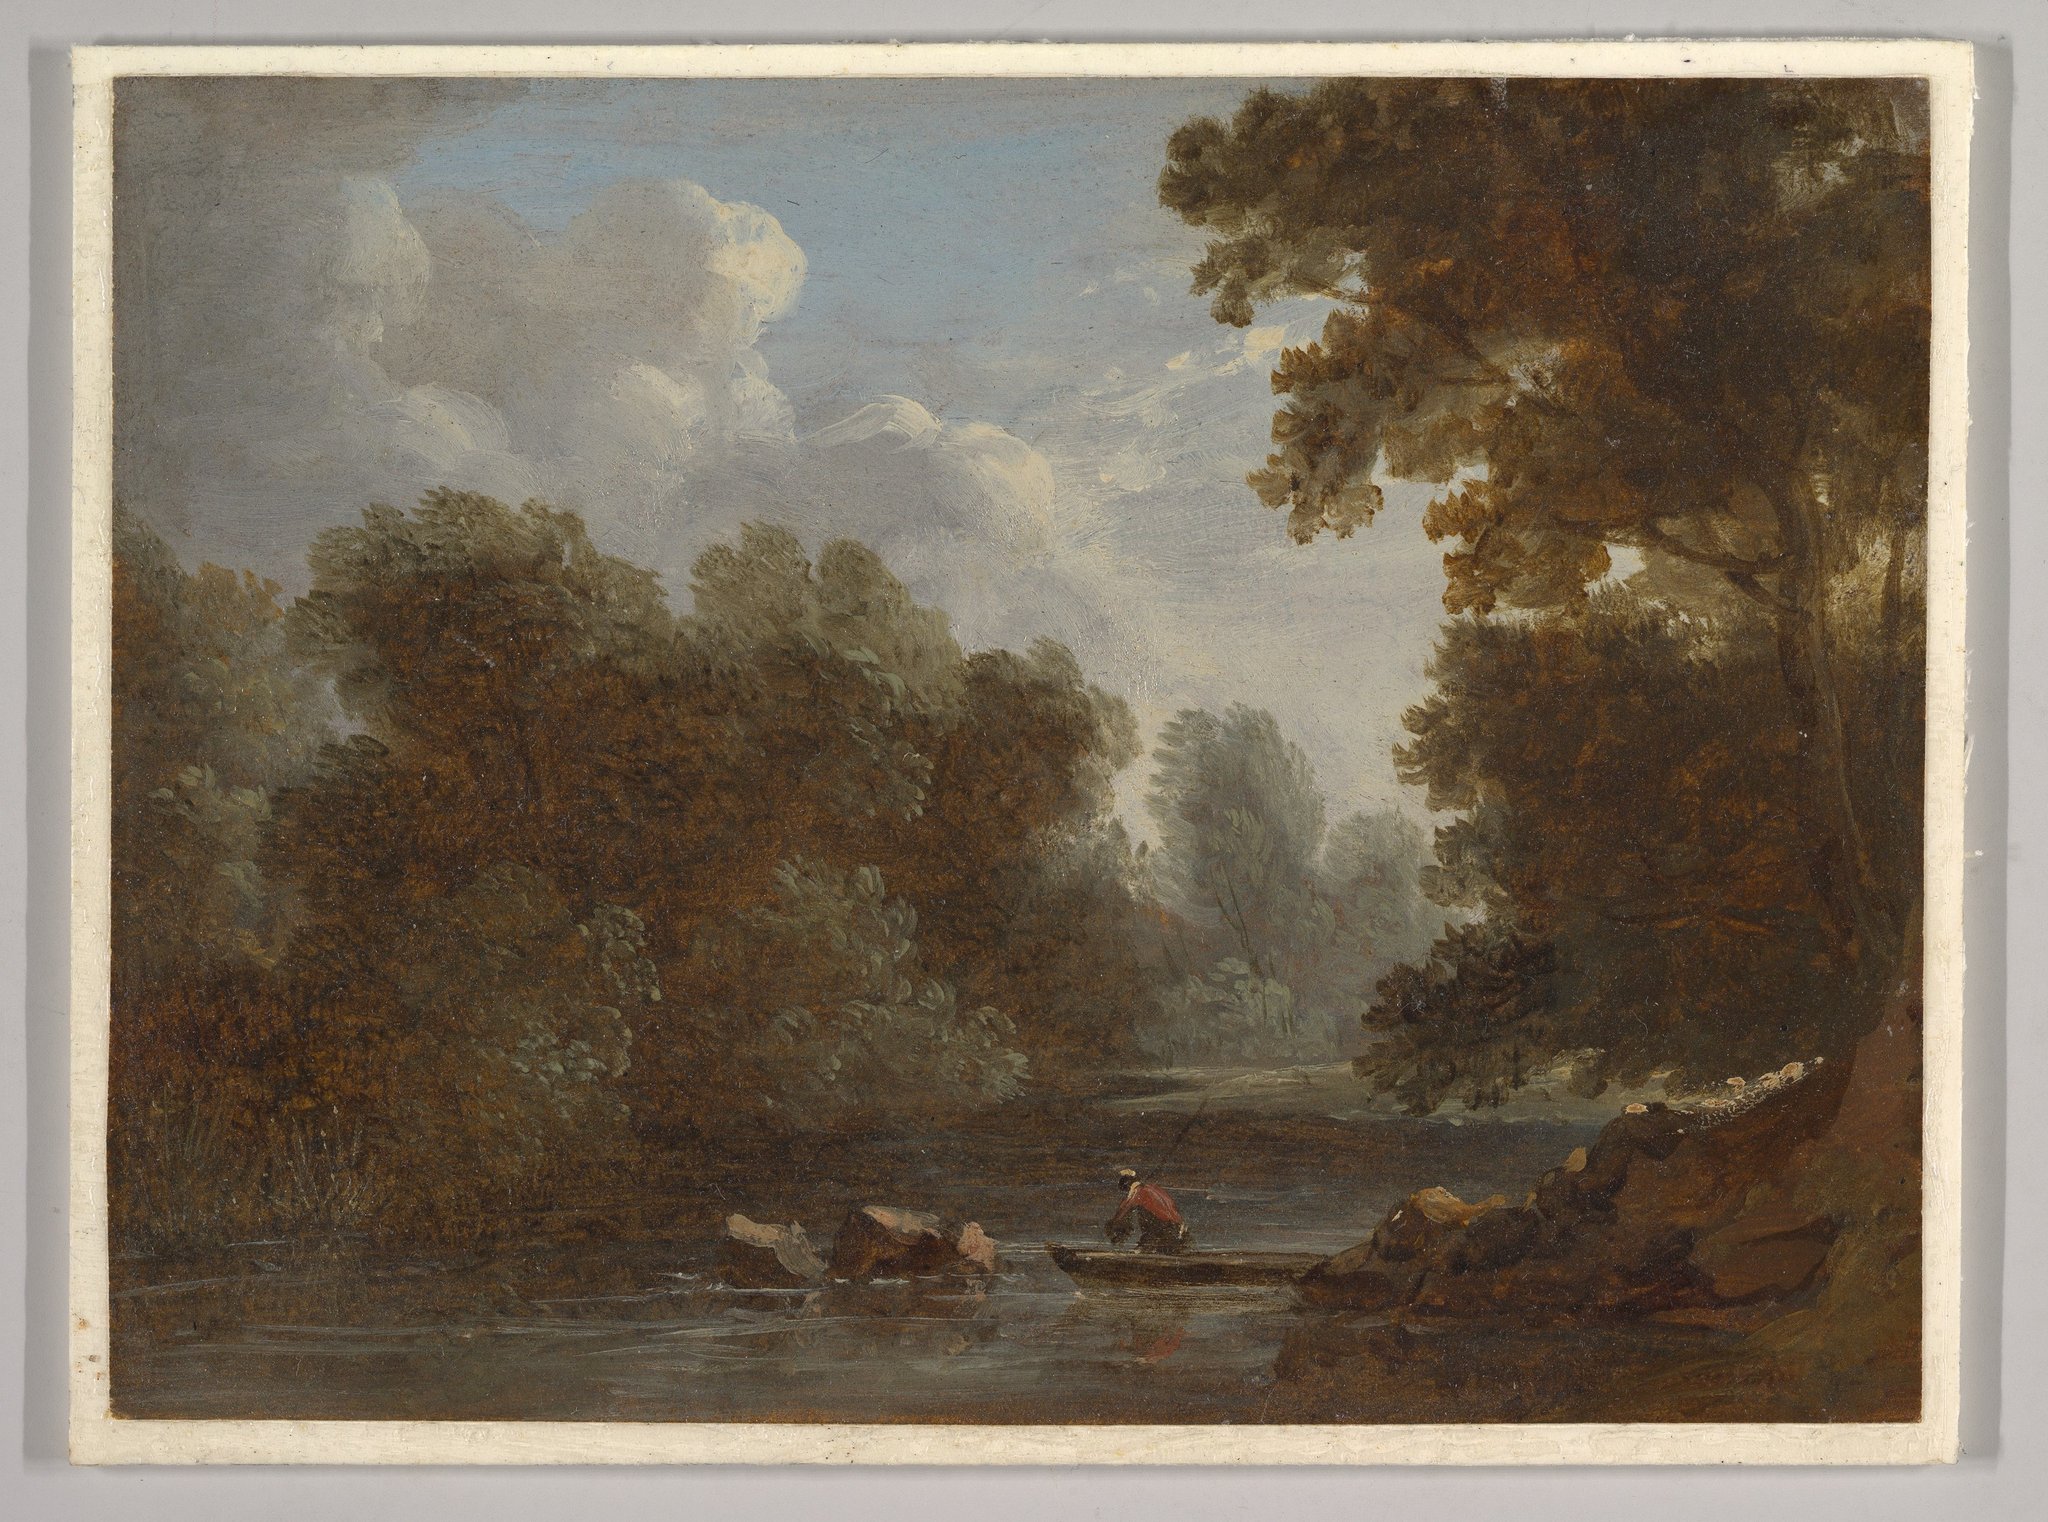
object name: drawing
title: A wooded river landscape with a fisherman in a boat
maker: benjamin barker, the younger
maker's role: artist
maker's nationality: british, welsh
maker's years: 1776-1838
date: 1826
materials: oil, paper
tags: men,fishing,landscapes,trees,boats